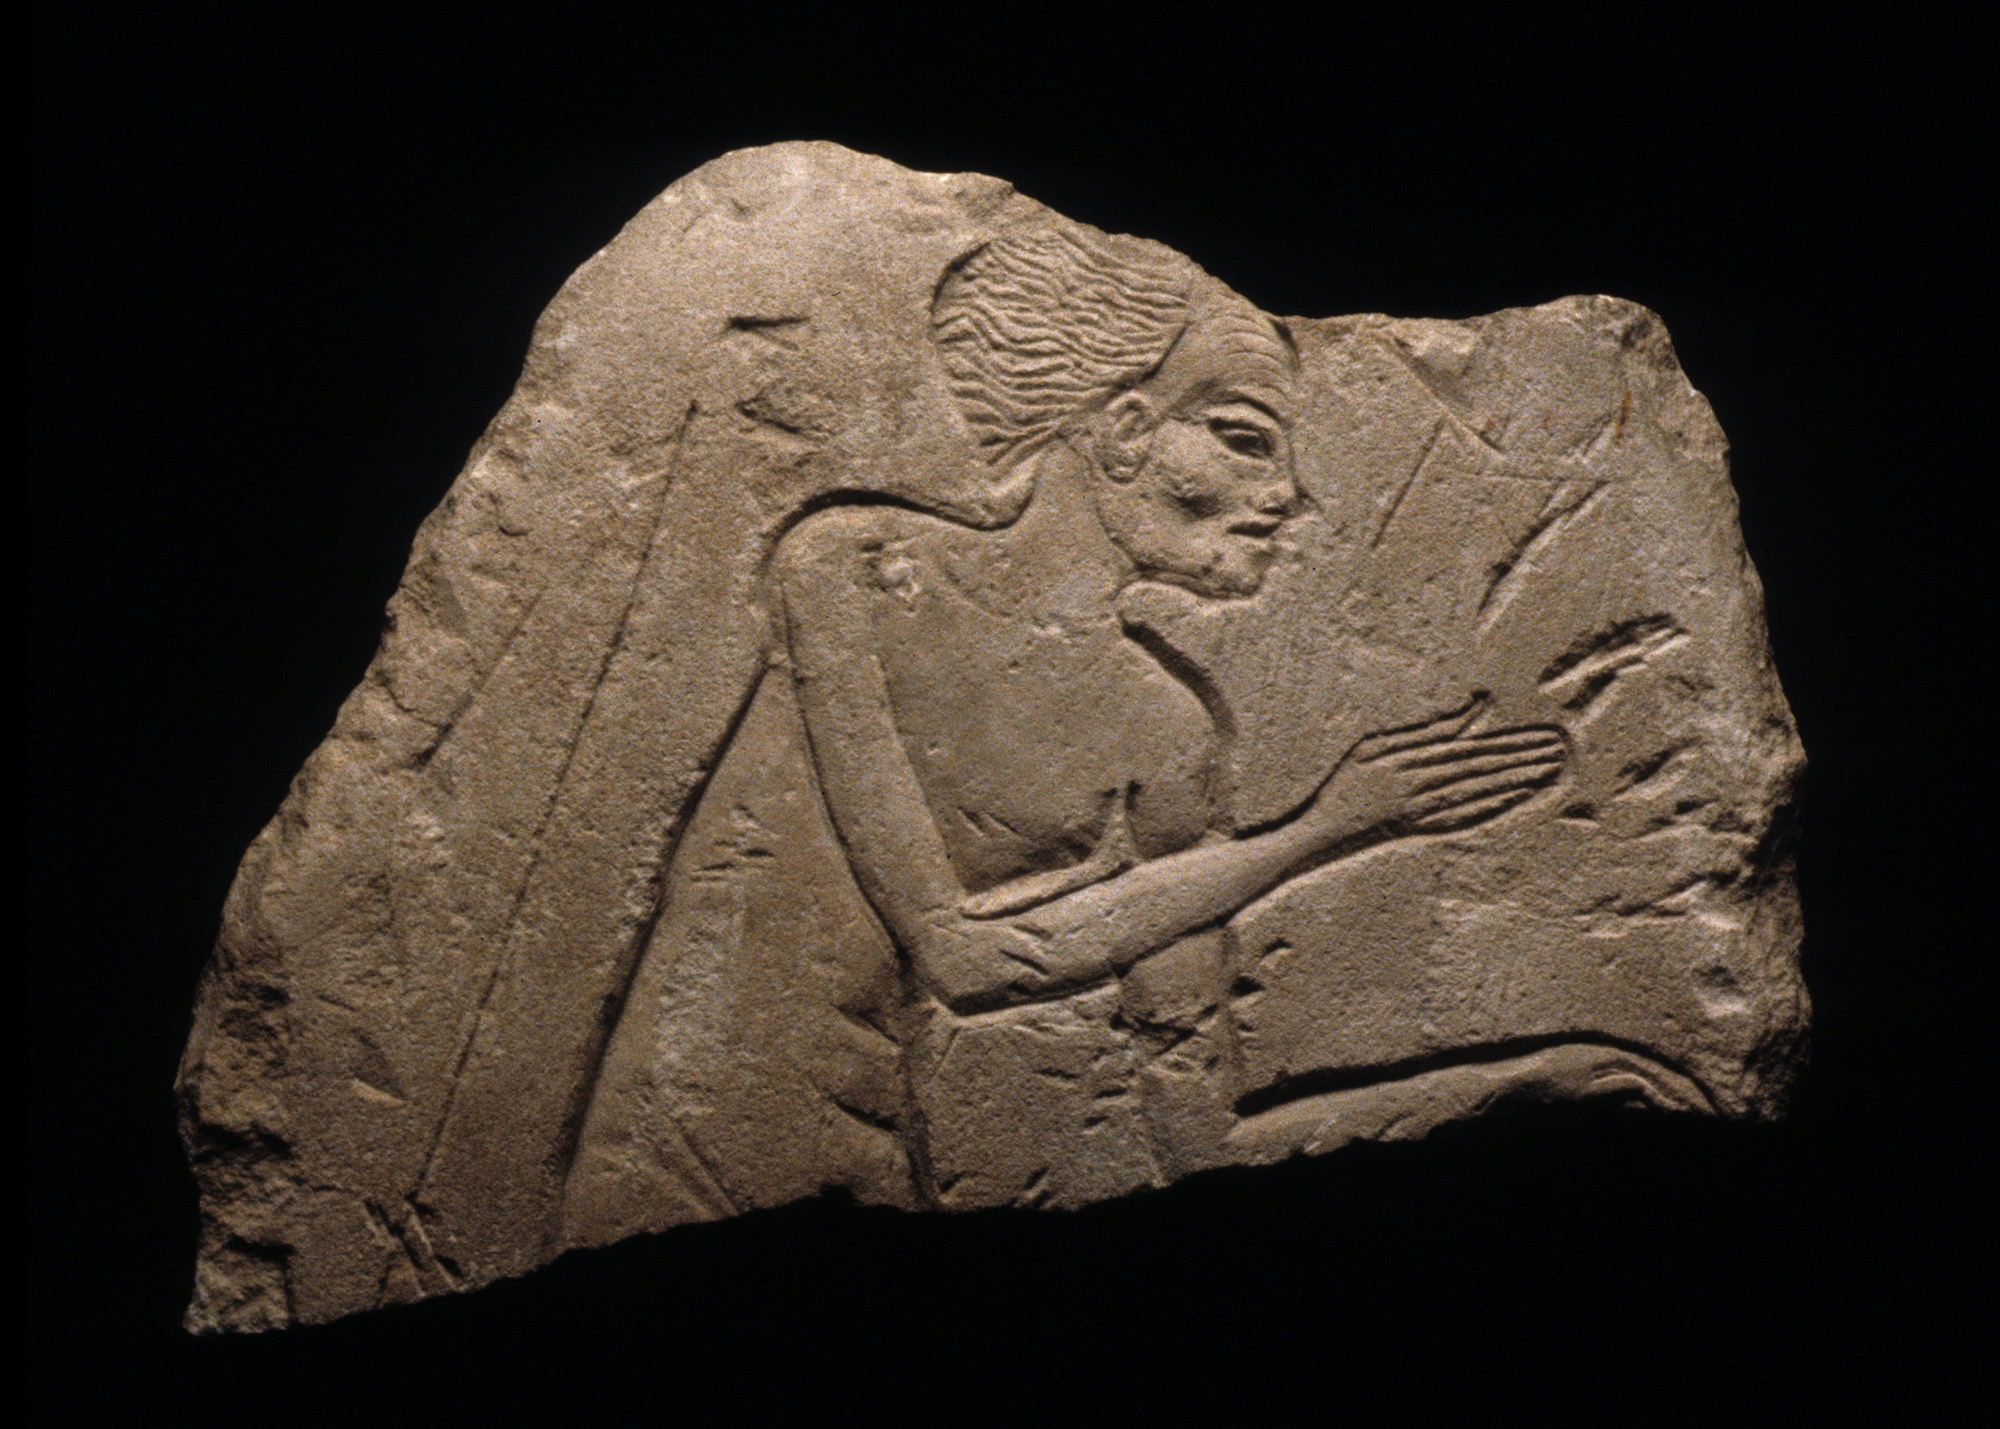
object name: trial piece, old man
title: Sculptor's Trial Piece showing an old man and on the reverse the lower part of a figure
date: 1352-1336 BCE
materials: limestone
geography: egypt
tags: men